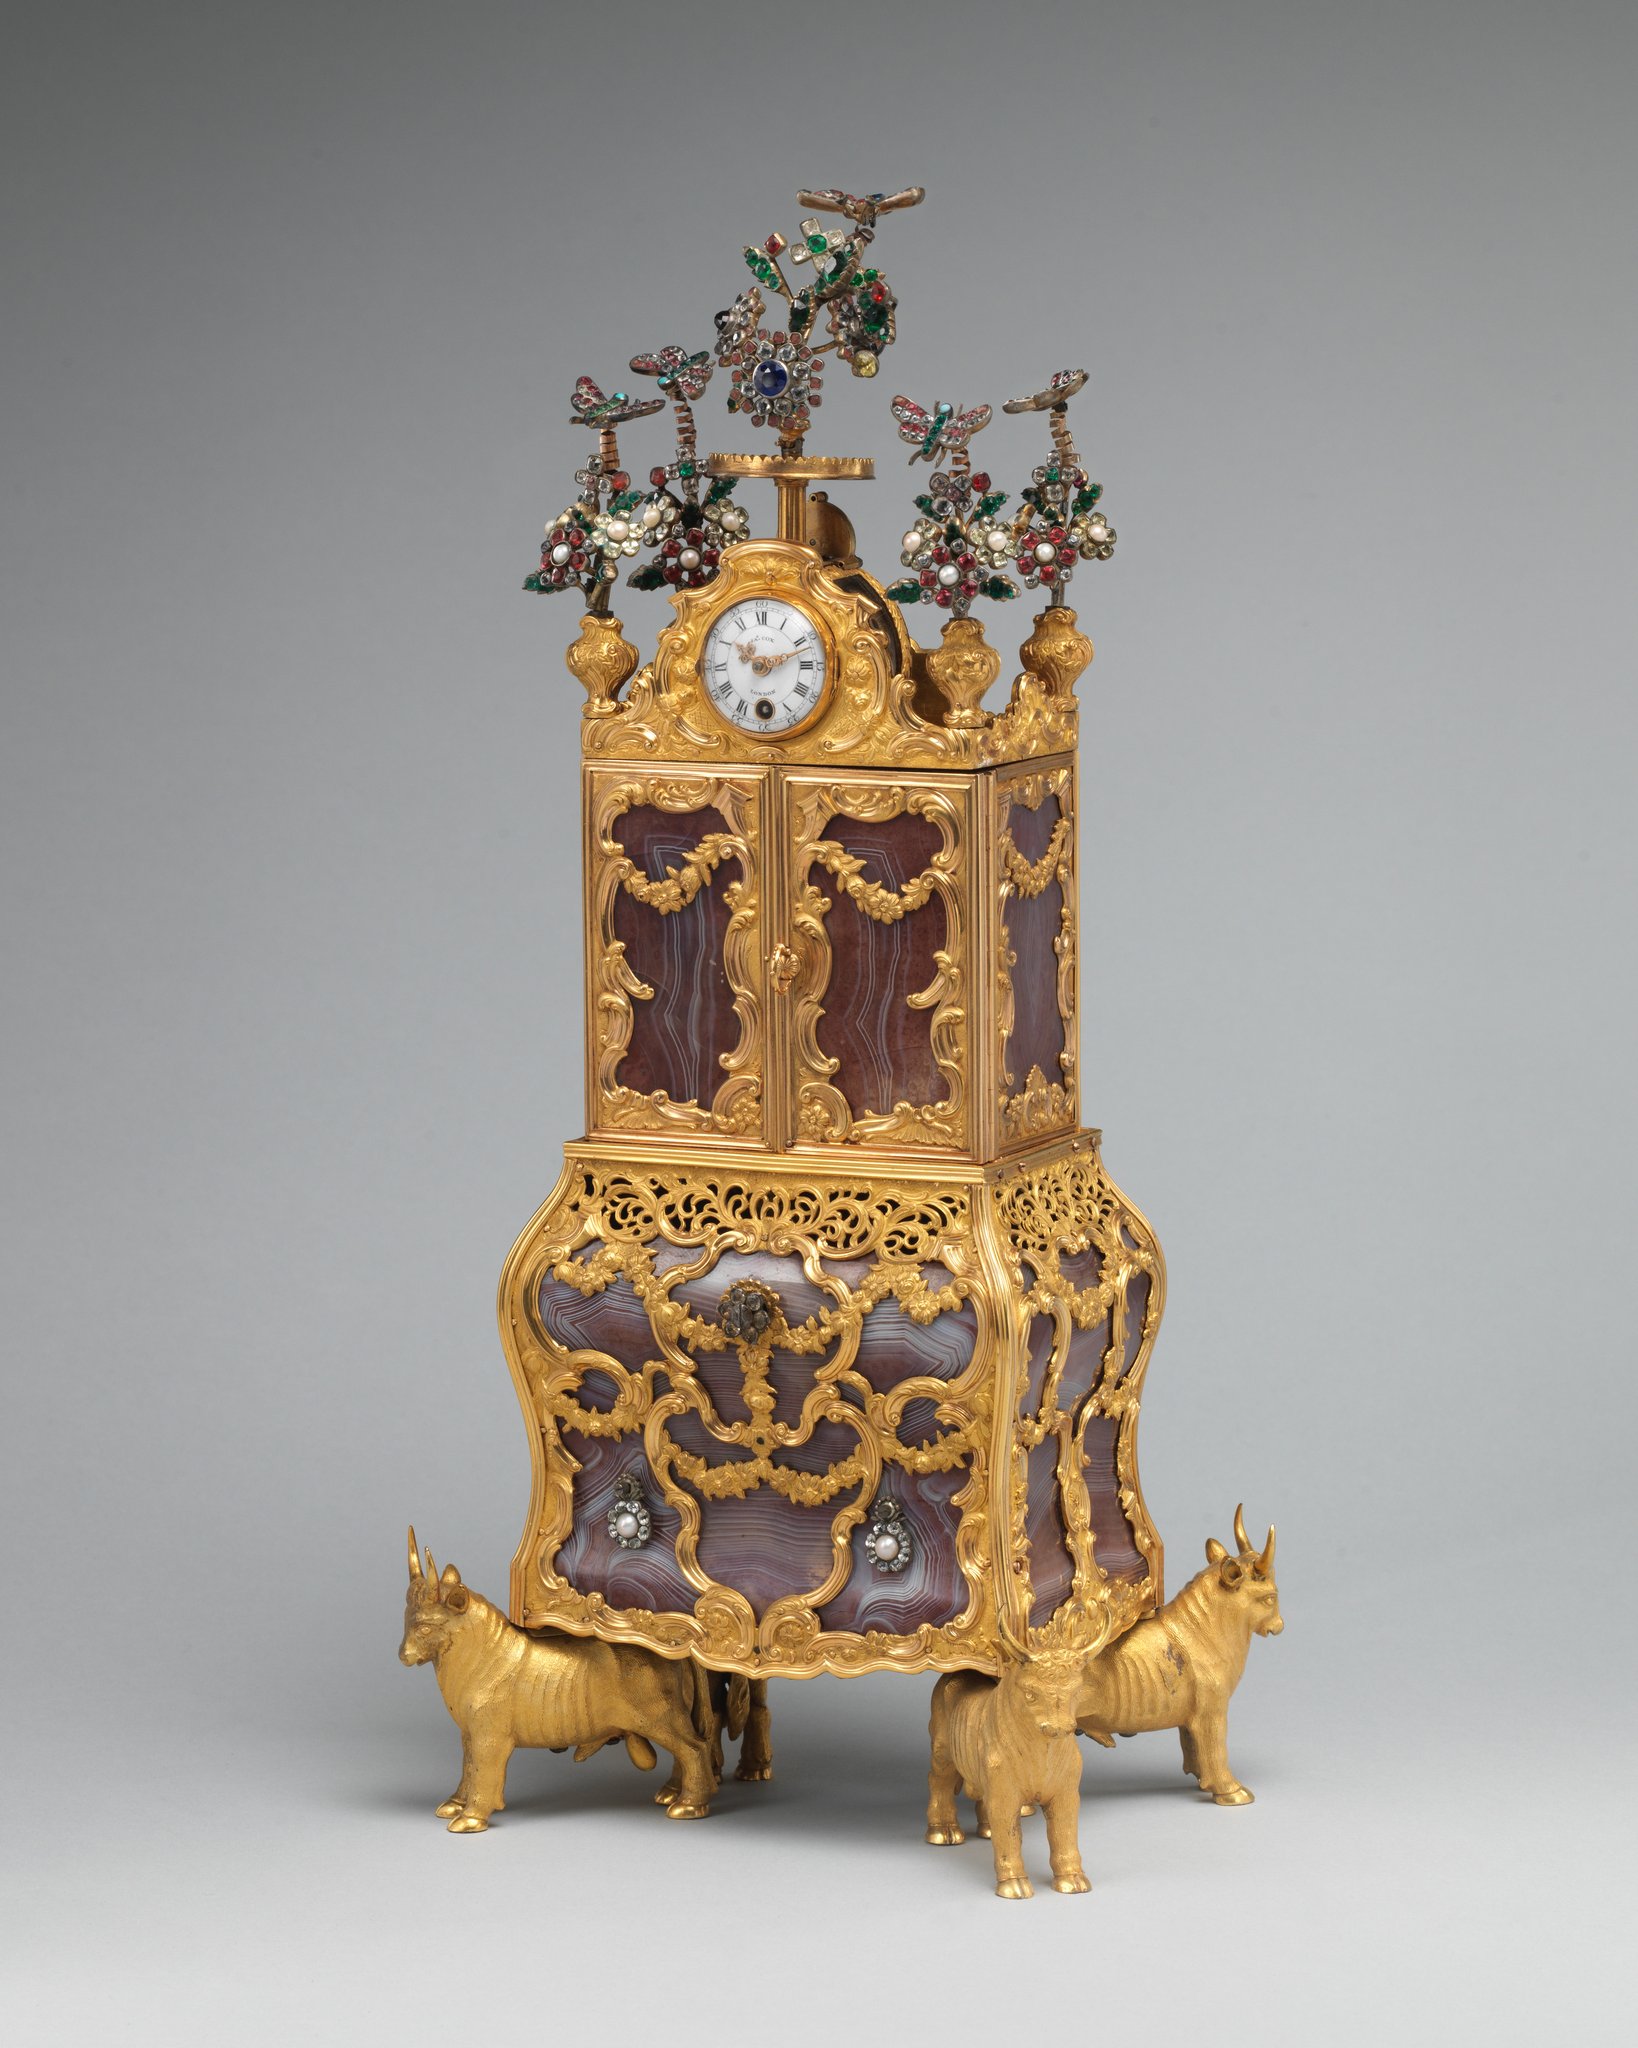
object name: miniature secretary incorporating a watch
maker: james cox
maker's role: entrepreneur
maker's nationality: british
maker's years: 1723-1800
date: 1766-1772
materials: stone, enamel, gilt brass, gold, paste, pearl, silver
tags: bulls,butterflies